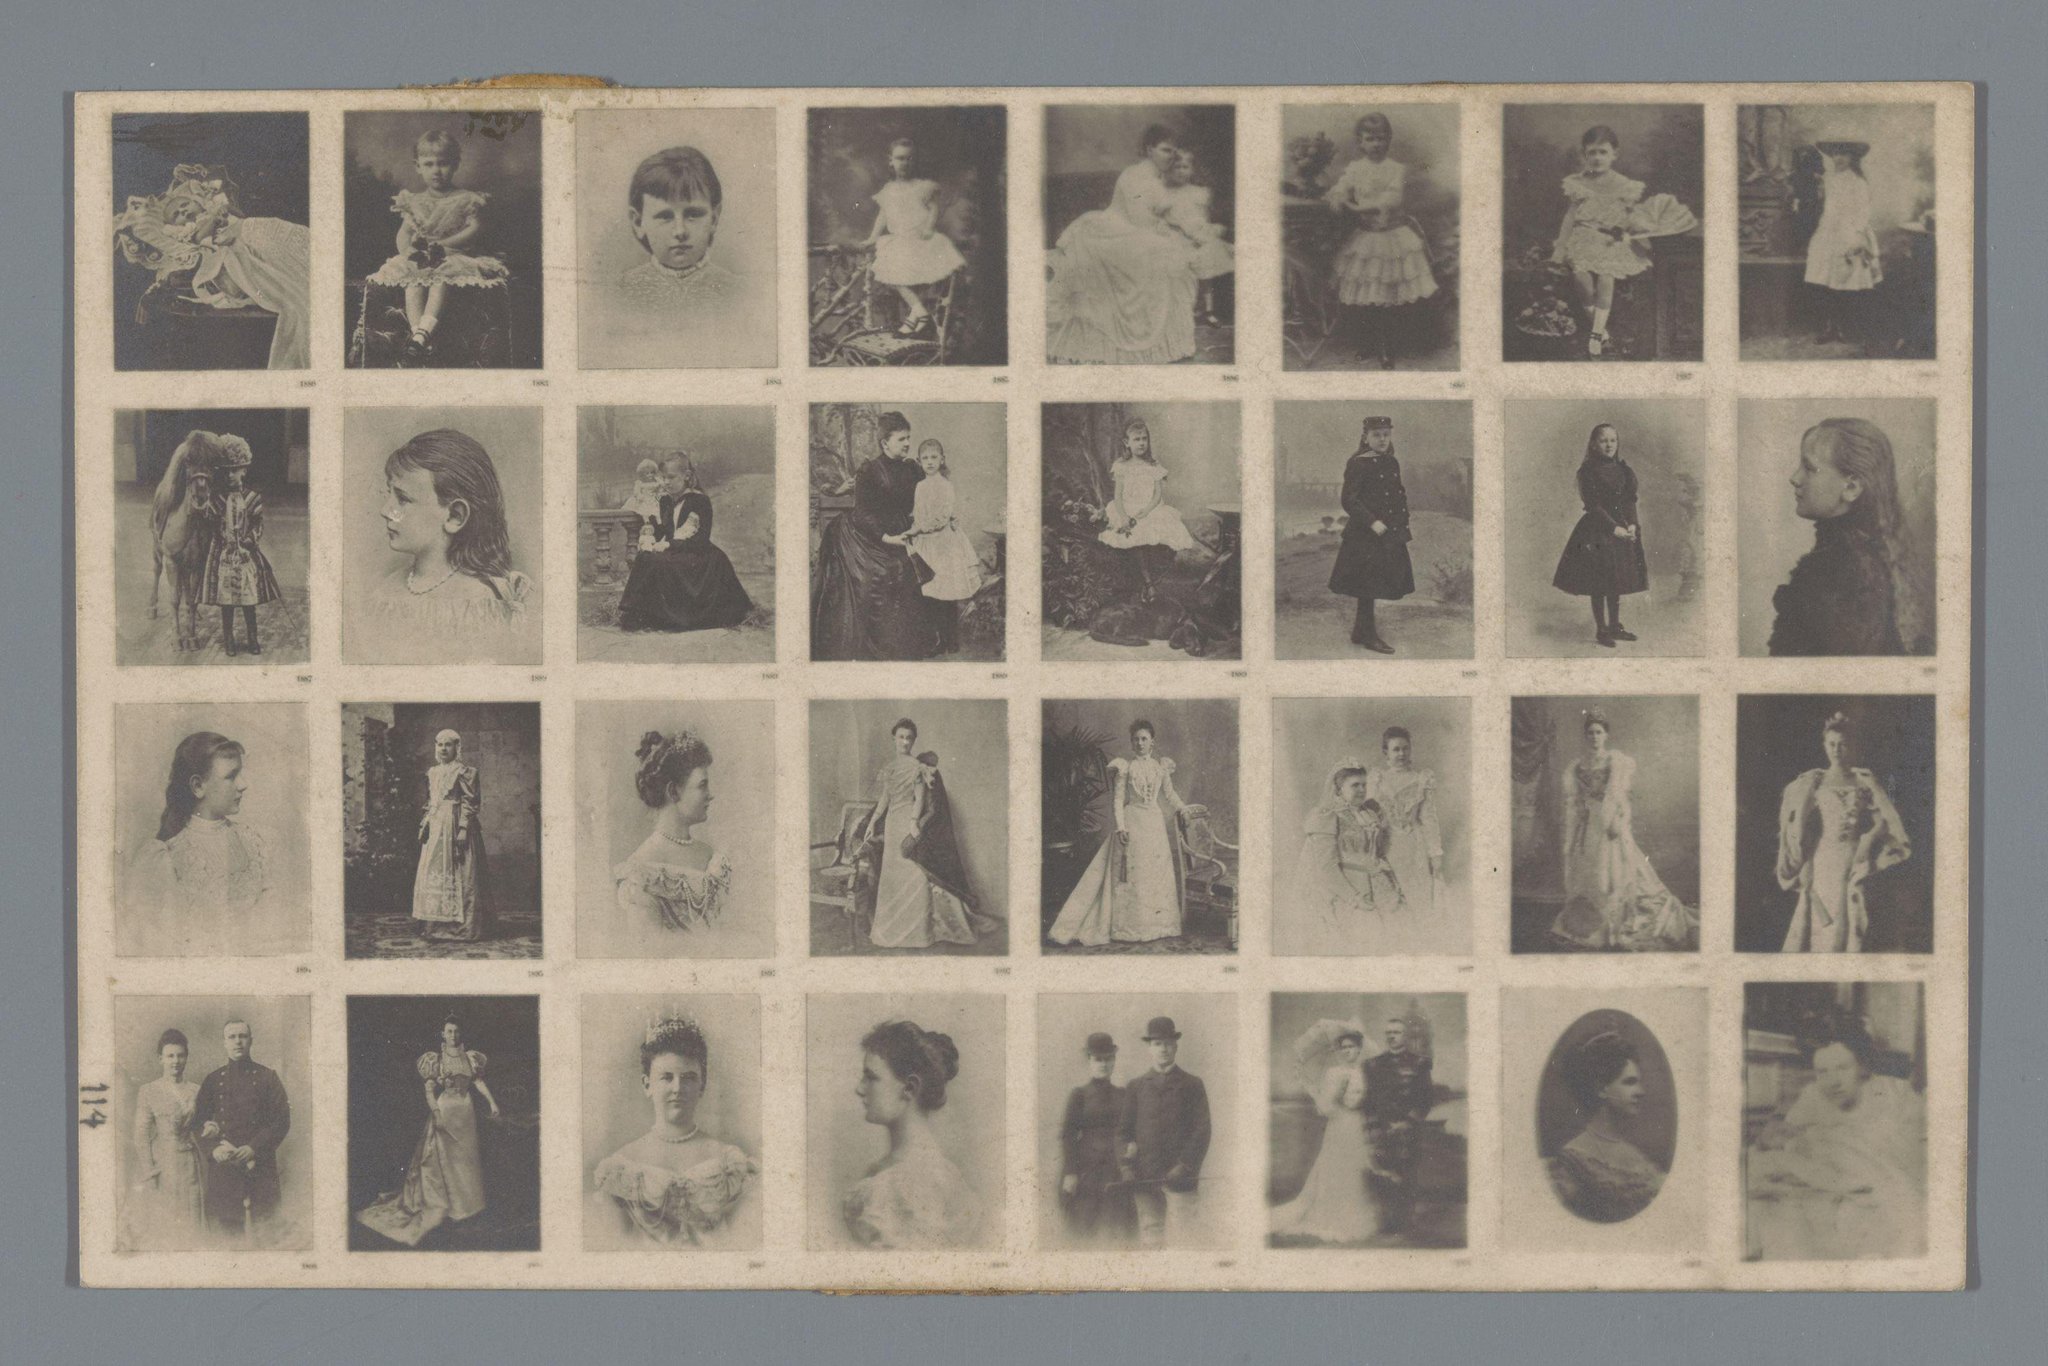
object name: photograph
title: H.M. koningin Wilhelmina. 31 Aug. 1880 van kind tot moeder, 30 April 1909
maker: Anonymous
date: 1909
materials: photographic support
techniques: gelatin silver print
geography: the hague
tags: wilhelmina of the netherlands, queen